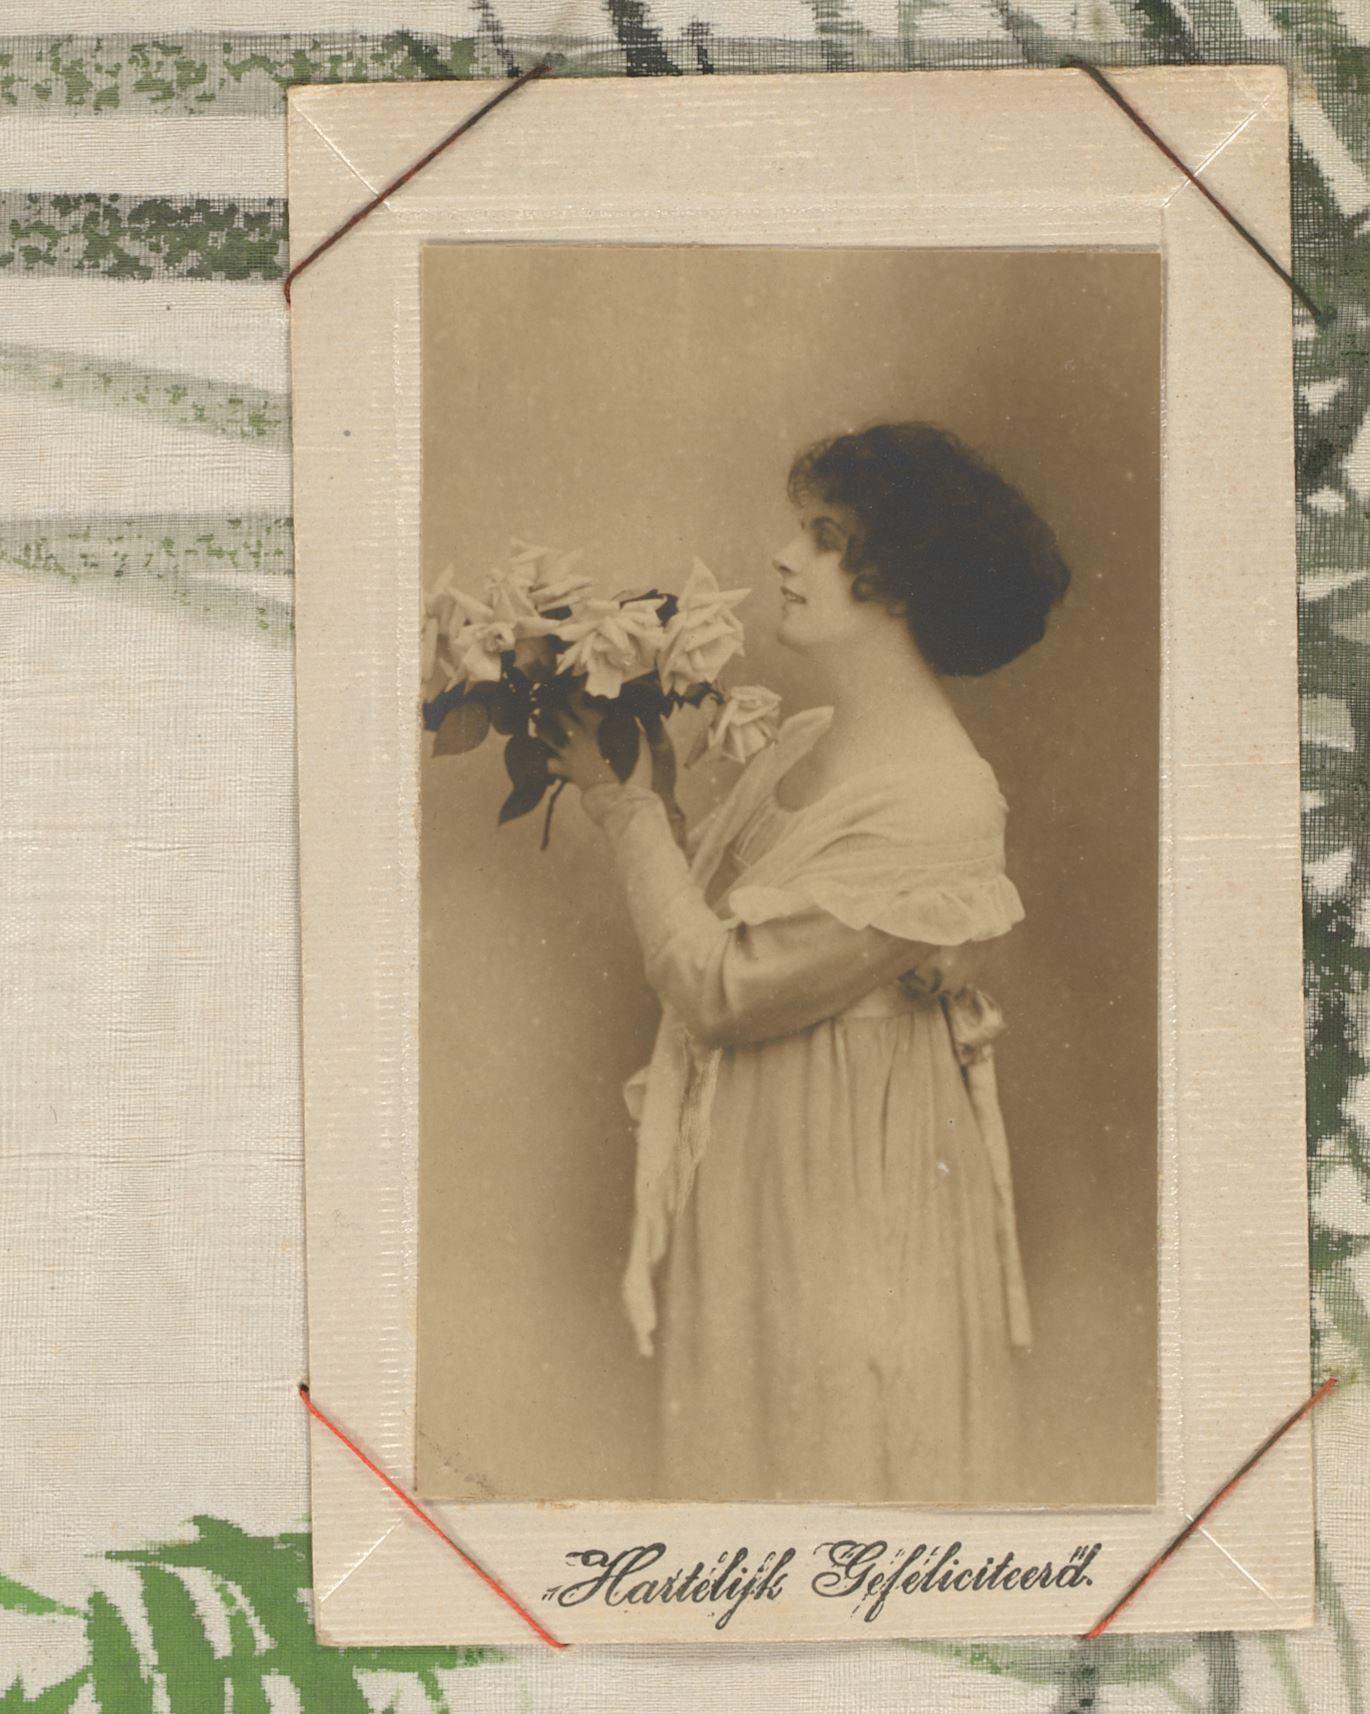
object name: ansichtkaart, prentbriefkaart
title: Portret van een vrouw met bloemen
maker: Anonymous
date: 1880-1920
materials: paint, photographic support, silk, textile, watercolor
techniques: brush, gelatin silver print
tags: flowers, adult woman, historical persons